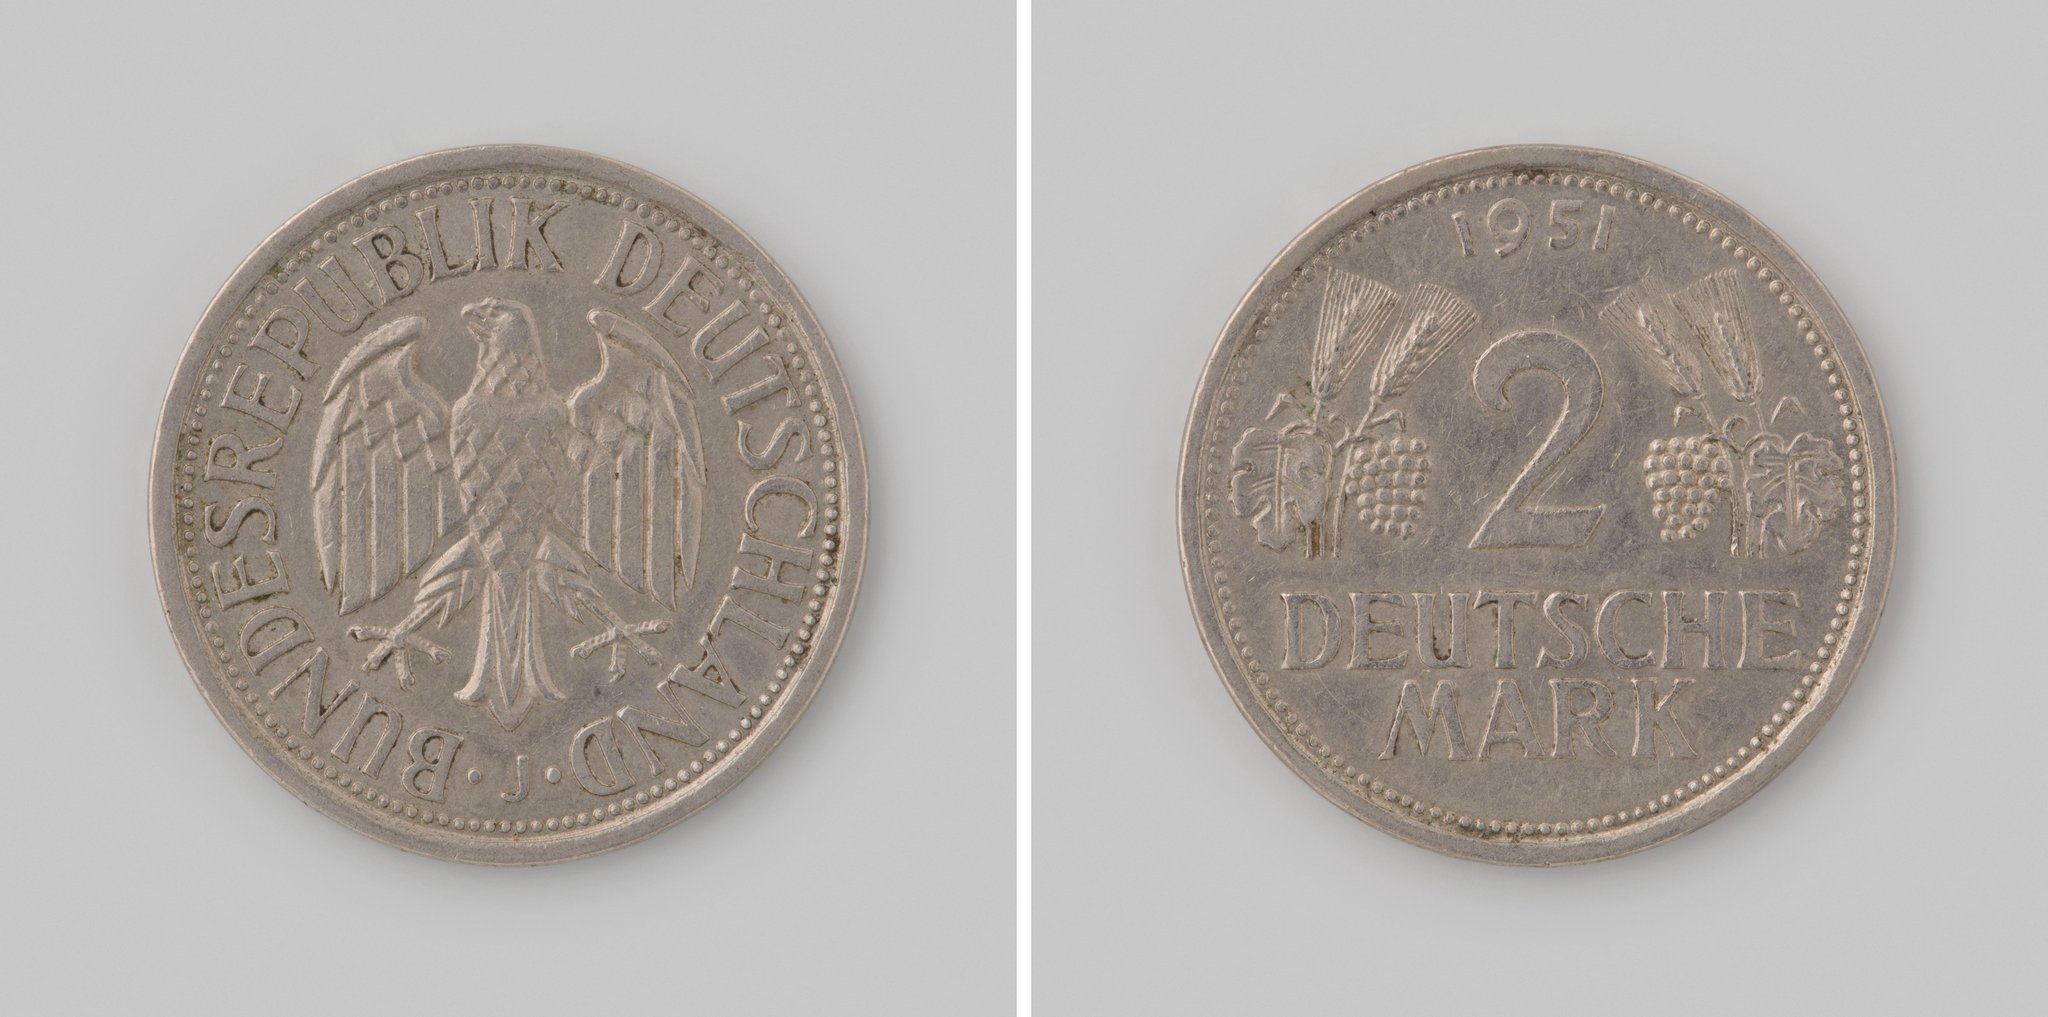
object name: coin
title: 2 Deutsche Mark uit Duitsland, Bondsrepubliek, 1951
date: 1951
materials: nickel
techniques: striking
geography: hamburg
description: Koper-nikkelen munt. Voorzijde: enkelkoppige adelaar naar links. Onderaan letter J. Keerzijde: tussen vruchten, bladeren en aren waarde-aanduiding in drie regels. Jaartal bovenaan. Randschrift.